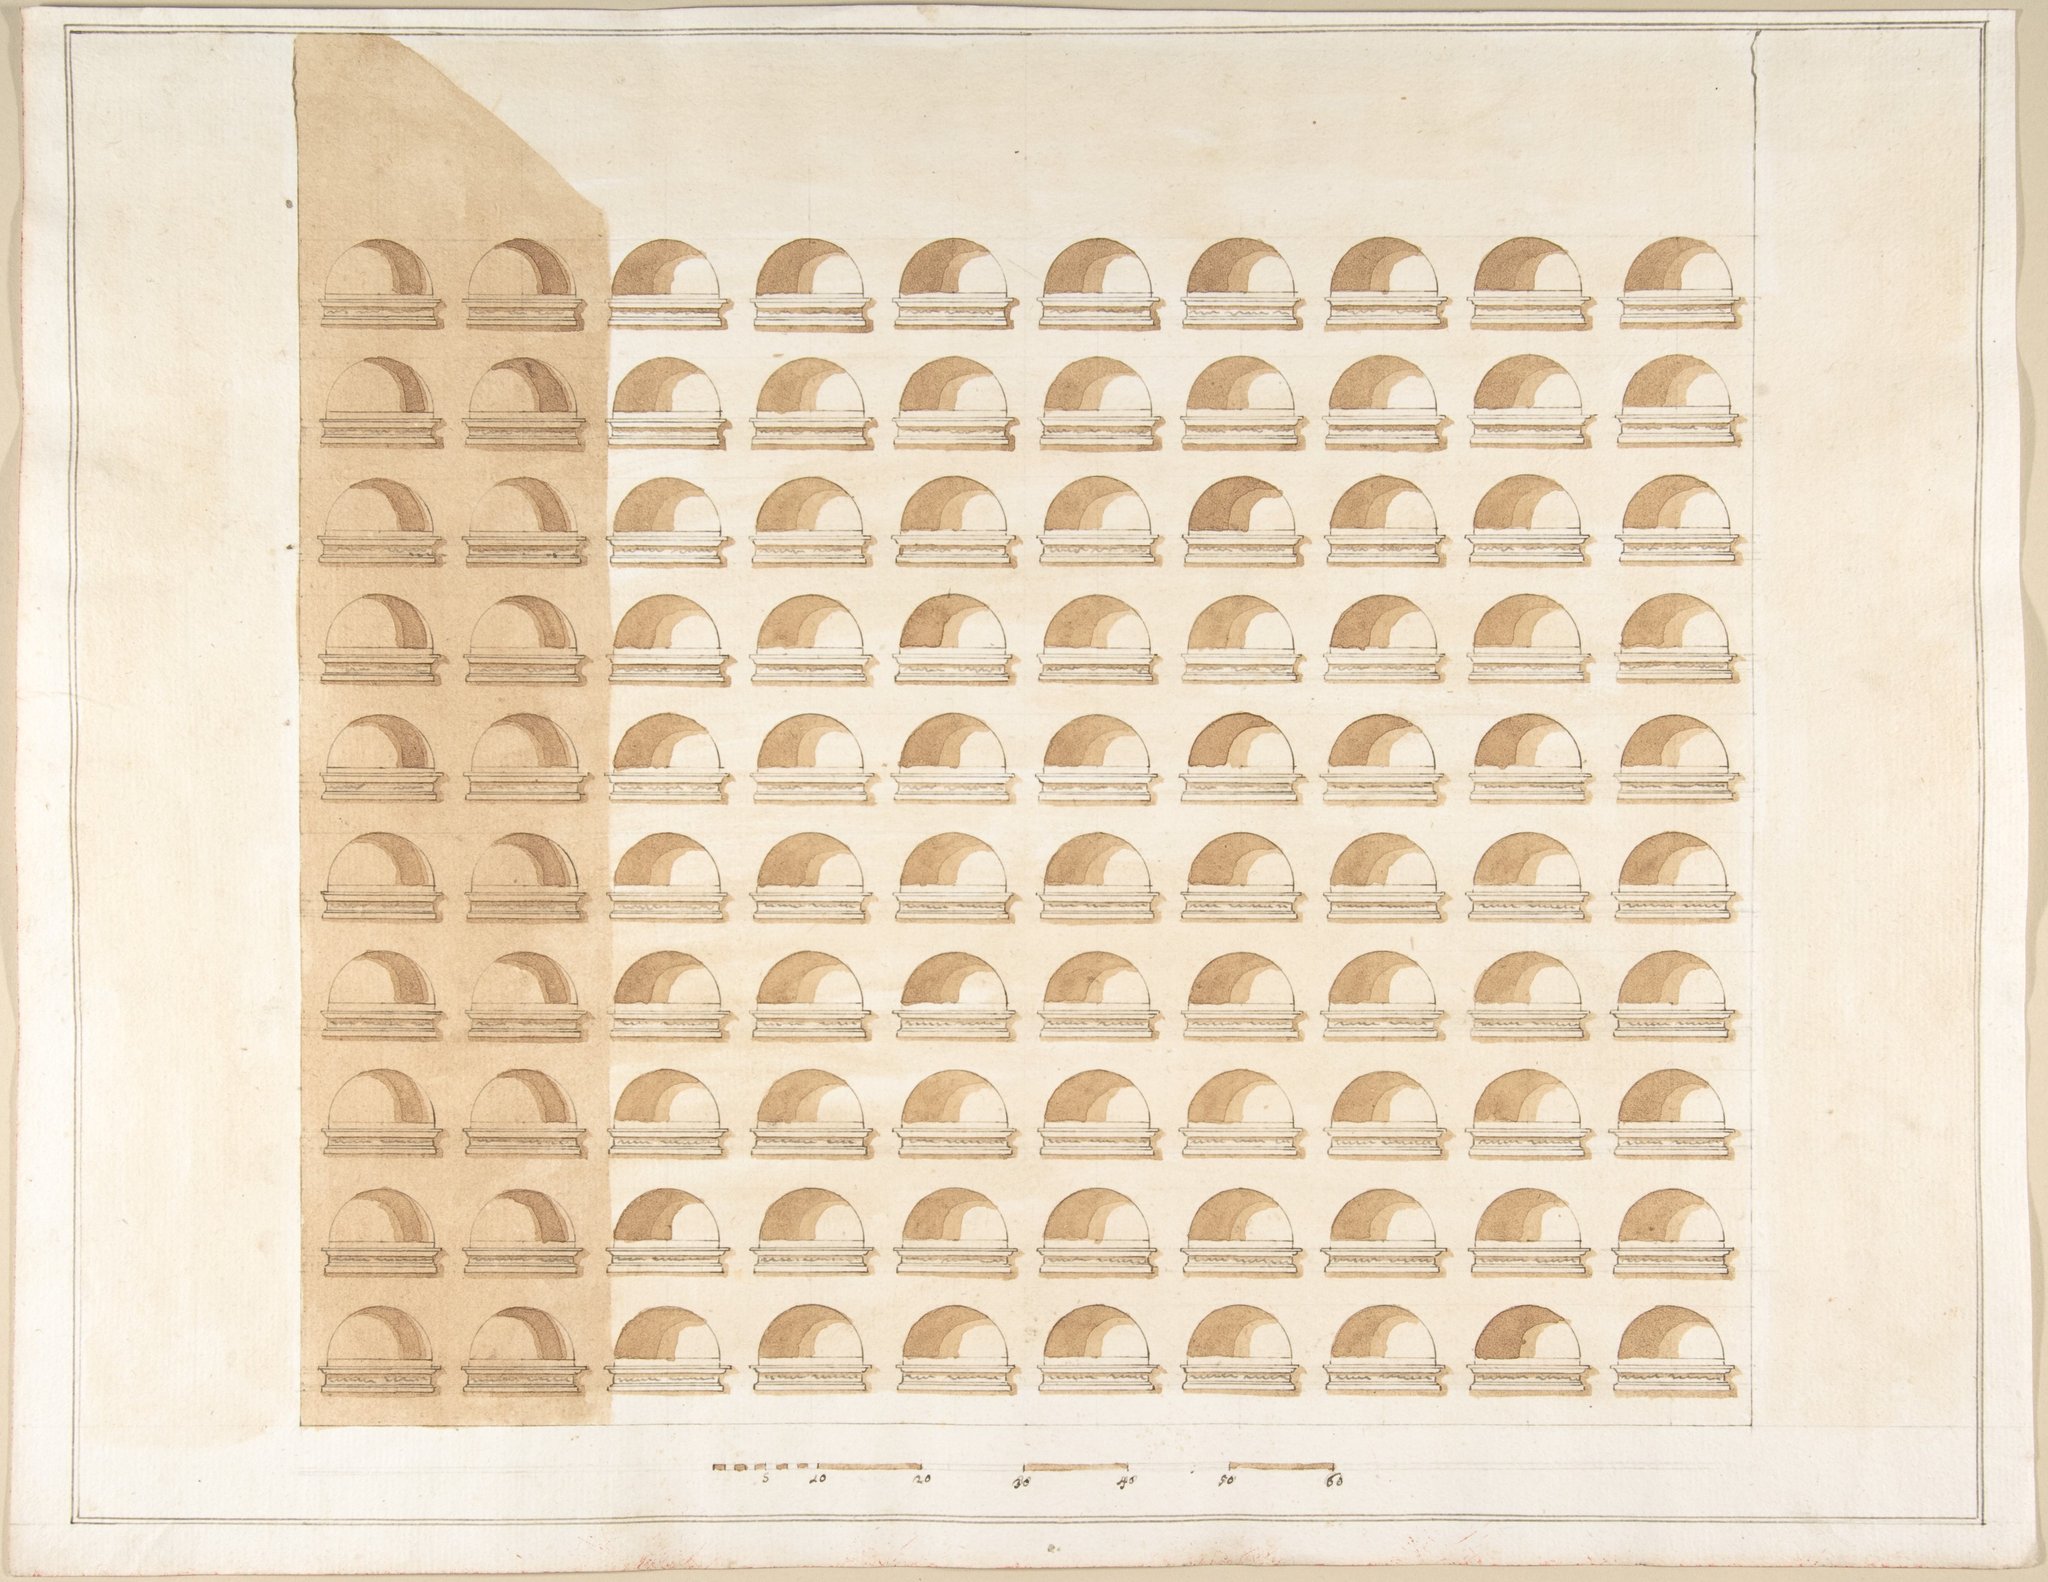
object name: drawing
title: Elevation of a Columbarium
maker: pietro paolo coccetti (cocchetti)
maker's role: artist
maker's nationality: italian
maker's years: 1710-1727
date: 1710-1727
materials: graphite, ink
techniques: brush, pen, wash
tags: architecture